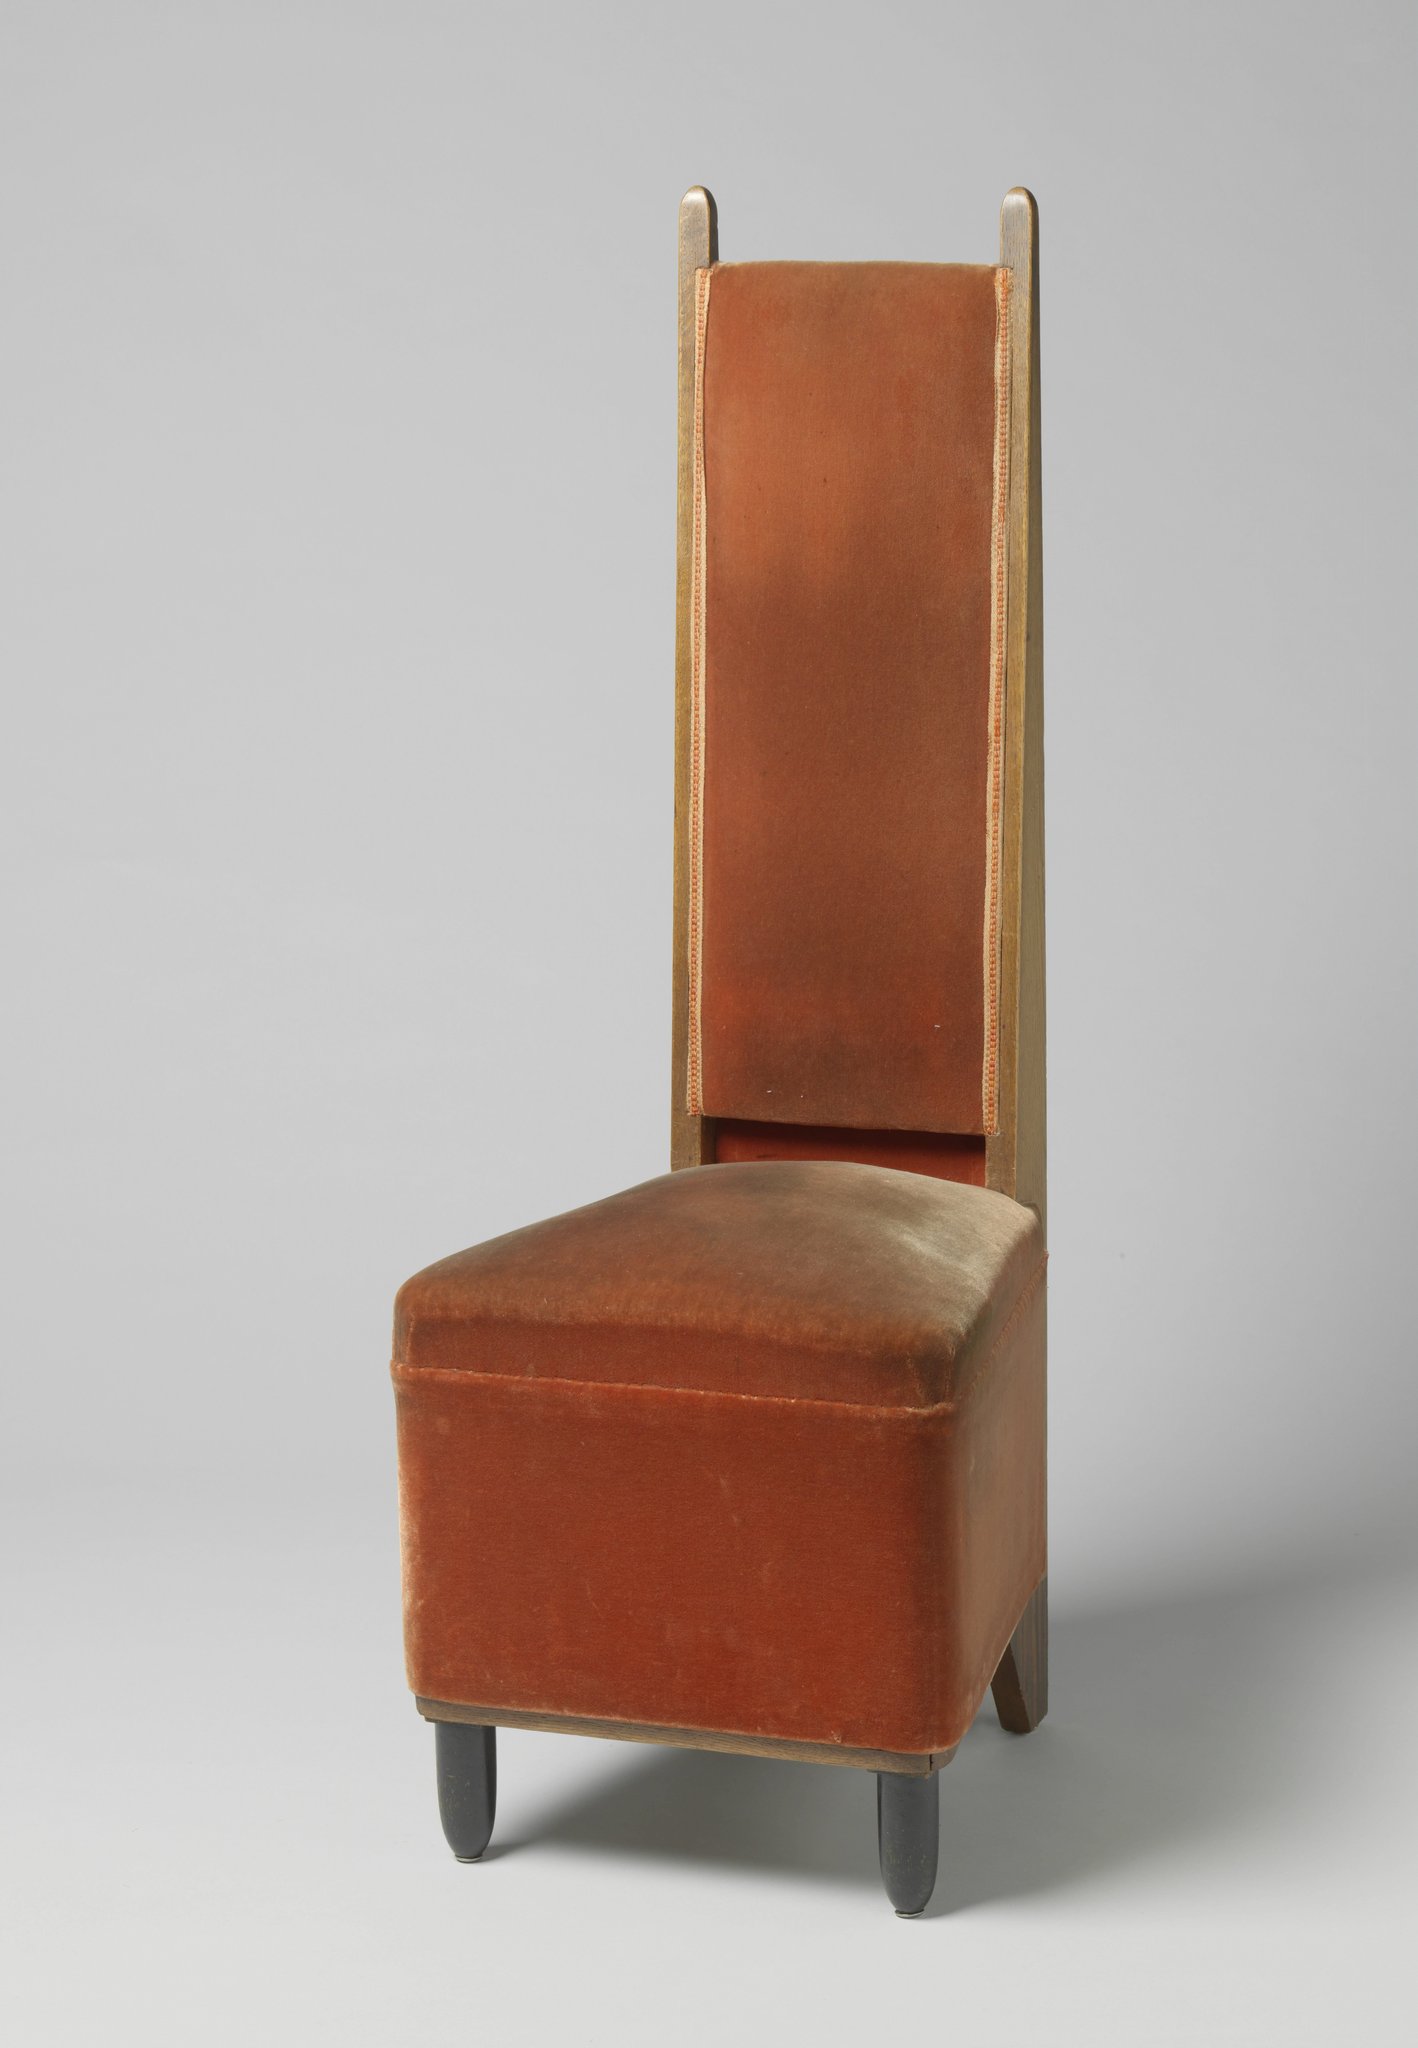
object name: chair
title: Stoel met hoge rug bekleed met oranje velours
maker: klaas van den berg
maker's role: designer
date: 1925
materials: wood, velvet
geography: amsterdam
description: Stoel van eikenhout, deels belijmd met palissanderhout, rustend op vier poten. De korte ronde voorpoten verjongen en zijn zwart geverfd; de achterpoten hebben één afgeschuinde zijde. De hoge trapeziumvormige zitting bevindt zich vlak boven de grond en is geheel bekleed met oranje velours. De hoge rug loopt naar boven smaller toe en is gevat in twee stijlen die uitsteken. De rug is tevens bekleed met oranje velours en is aan de zijkanten afgezet met een beige bies.